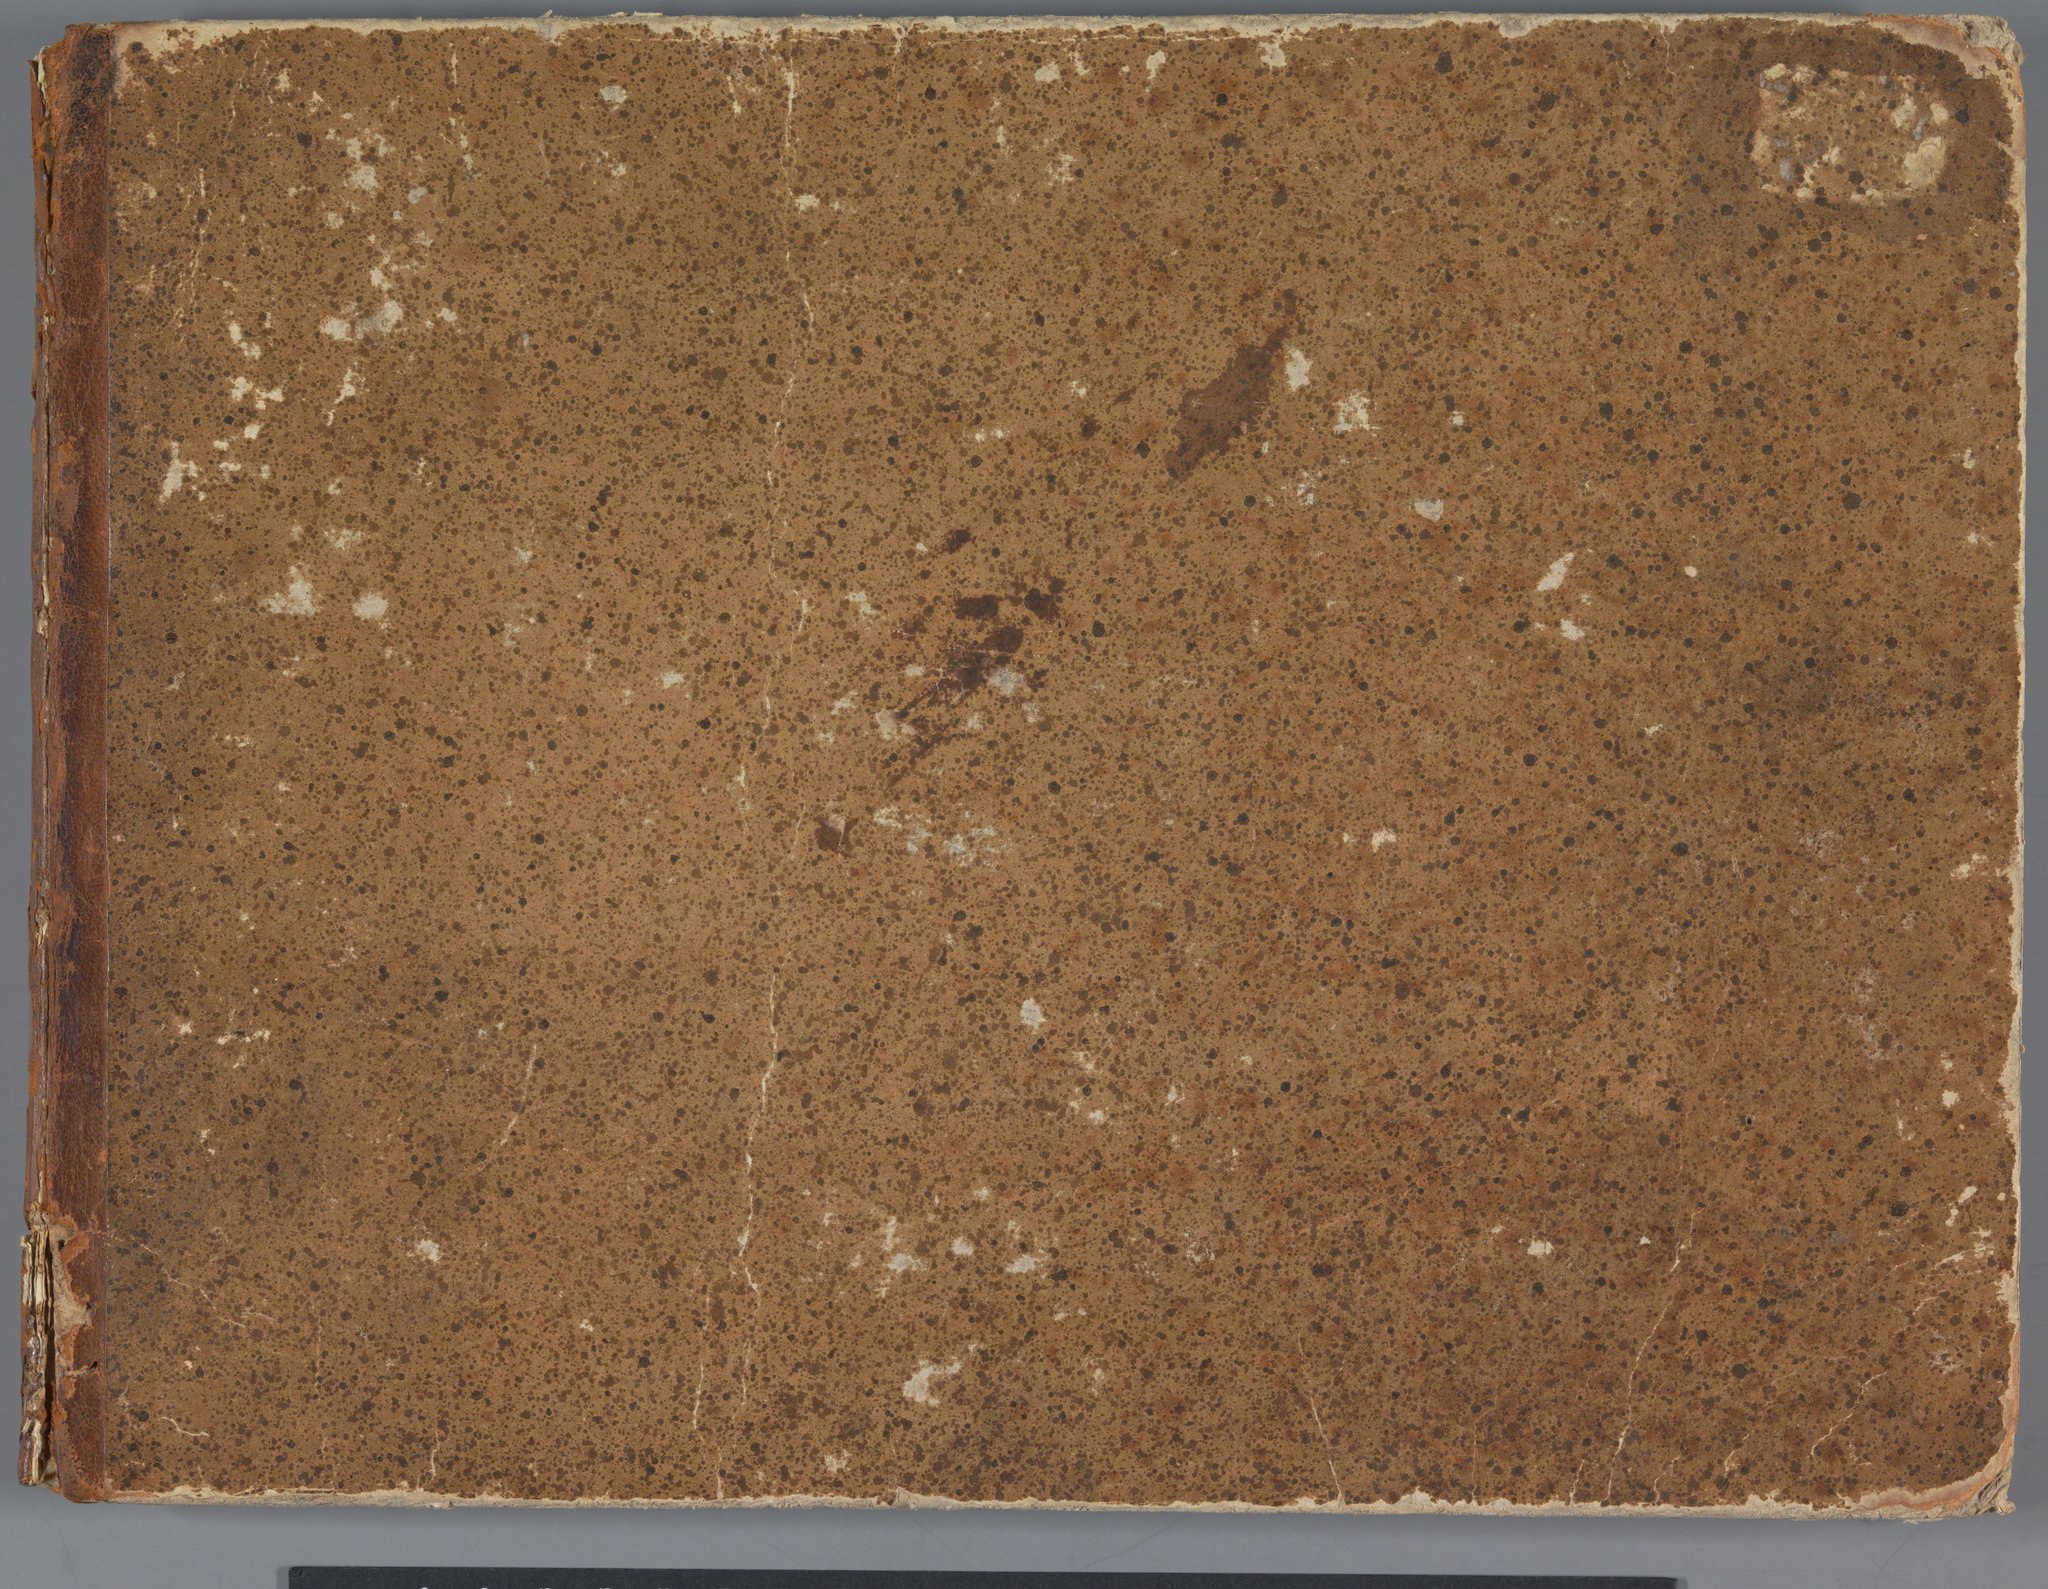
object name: prentrecueil, prentenalbum, prentalbum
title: Album met voorstellingen van de werken van Odysseus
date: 1633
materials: leather, paper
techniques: bookbinding, engraving, etching, letterpress printing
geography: paris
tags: adventures of the greeks after the fall of troy: the wanderings of ulysses (homer, odyssey)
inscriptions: collector's mark: Lugt 2166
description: Album met 62 voorstellingen op 62 albumbladen. Het album bevat de serie getiteld: Les Traveaux d'Ulysse, 1633. Het betreffen voorstellingen van de werken van Odysseus, gegraveerd naar de muurschilderingen in het koninklijk paleis van Fontainebleau. Voorstelling 39 uit de reeks zit twee keer in dit album. Halfleren band met marmeren platten, voorin en achterin een schutblad.